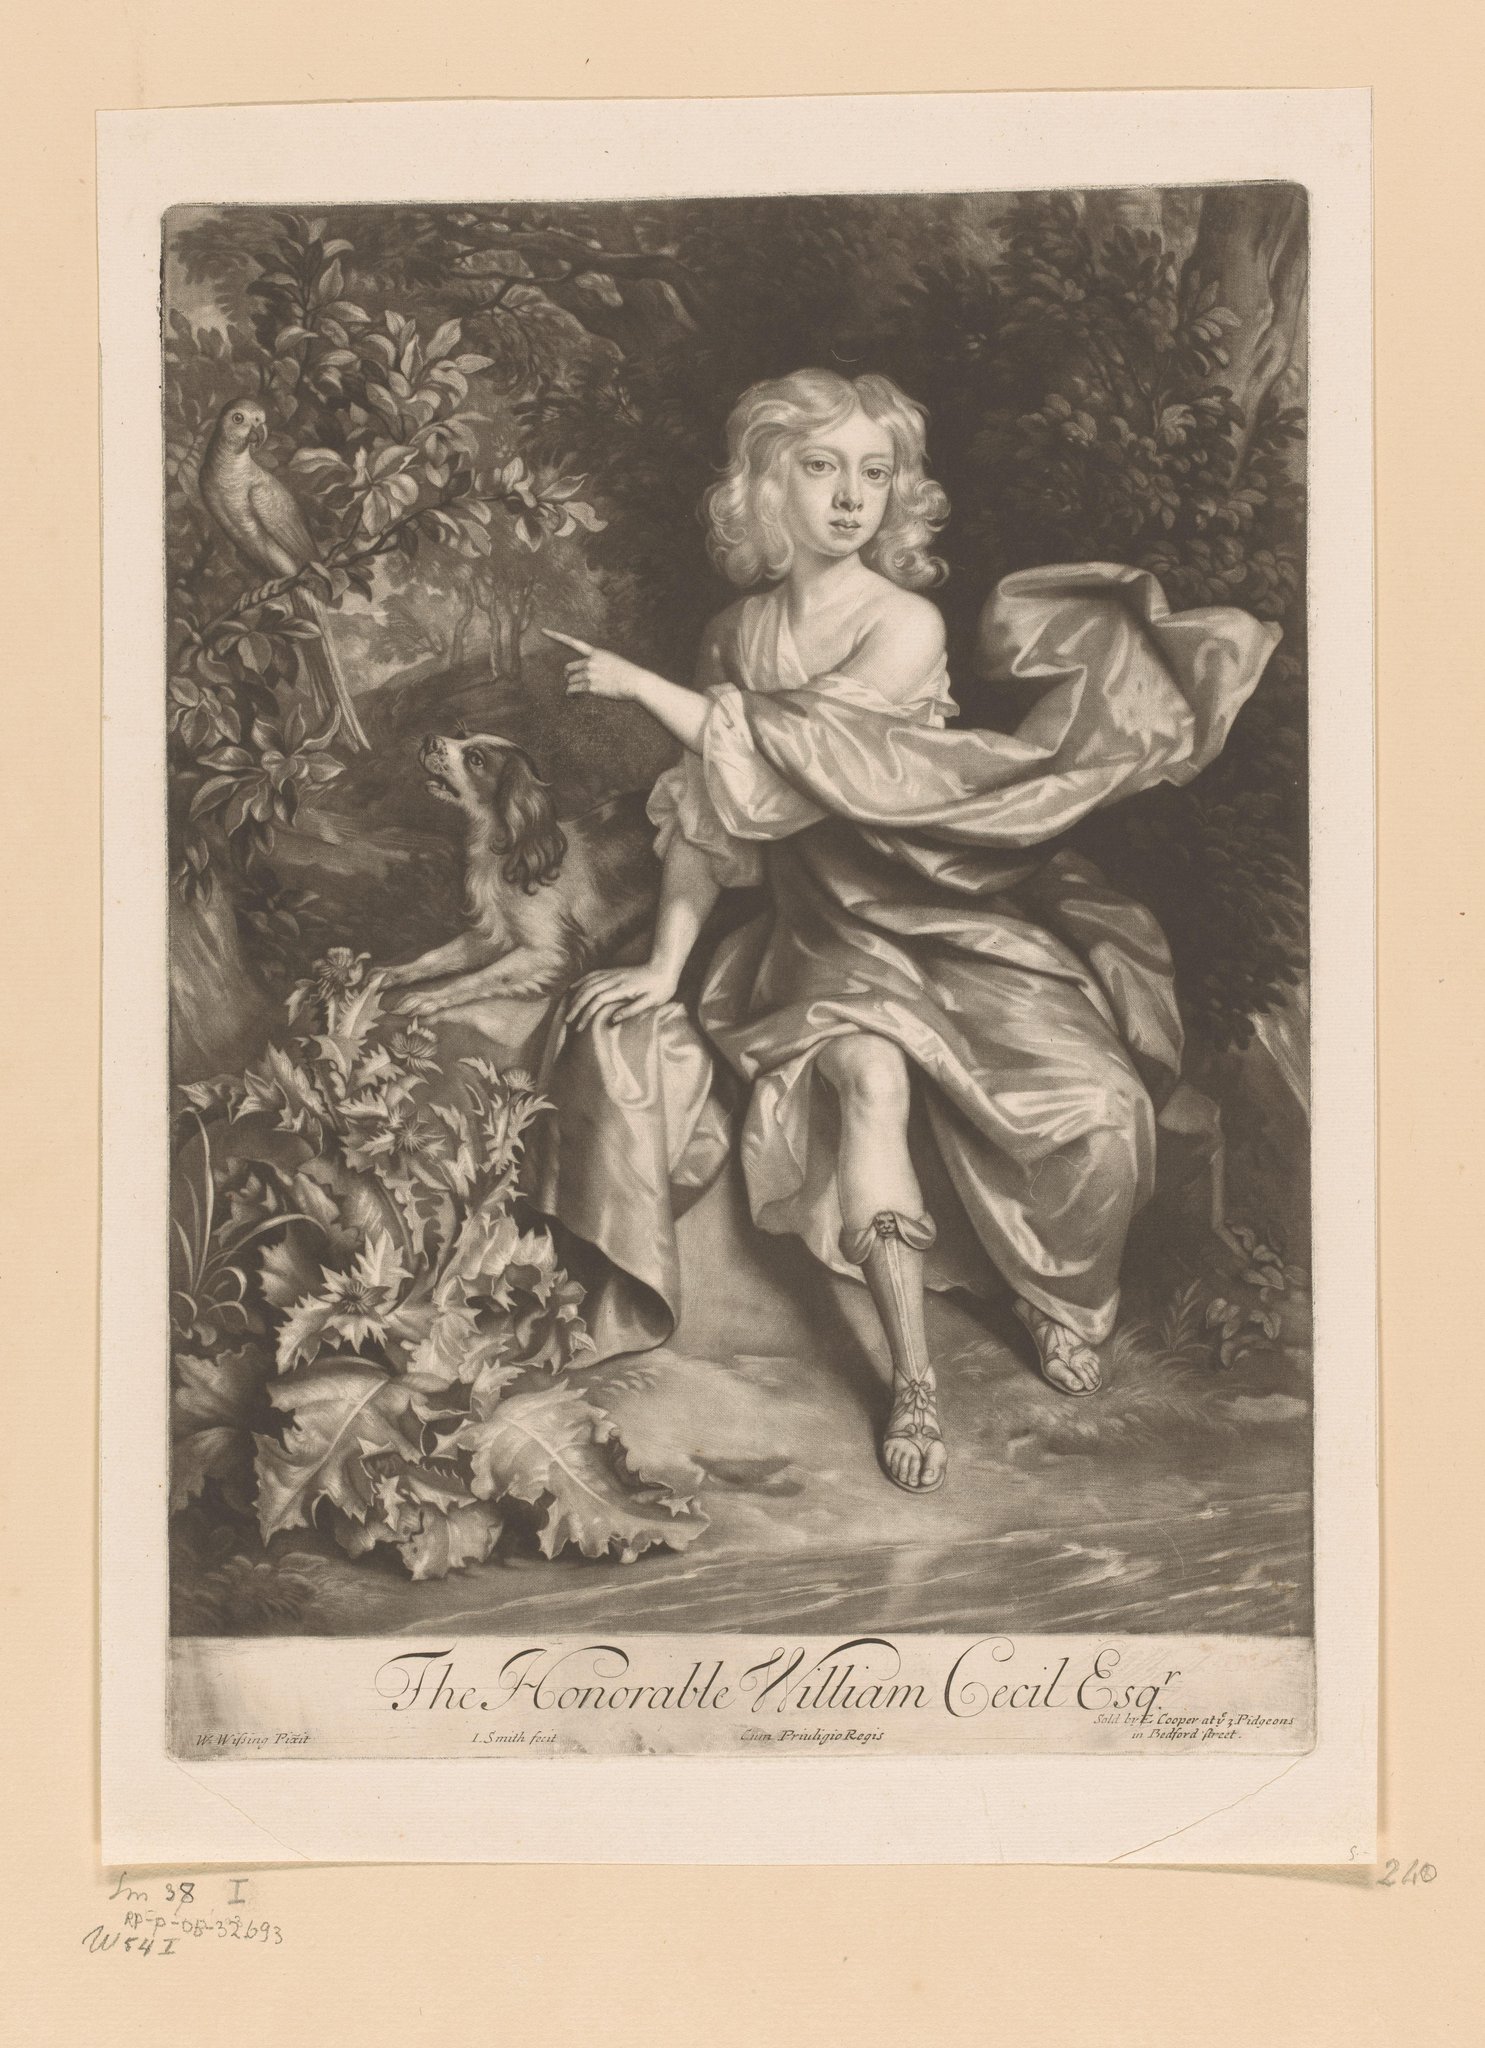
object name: print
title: Portret van William Cecil Esqr.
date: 1686-1725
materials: paper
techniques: mezzotint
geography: london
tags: historical persons, politician, e.g. party leader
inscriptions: collector's mark: Lugt 240